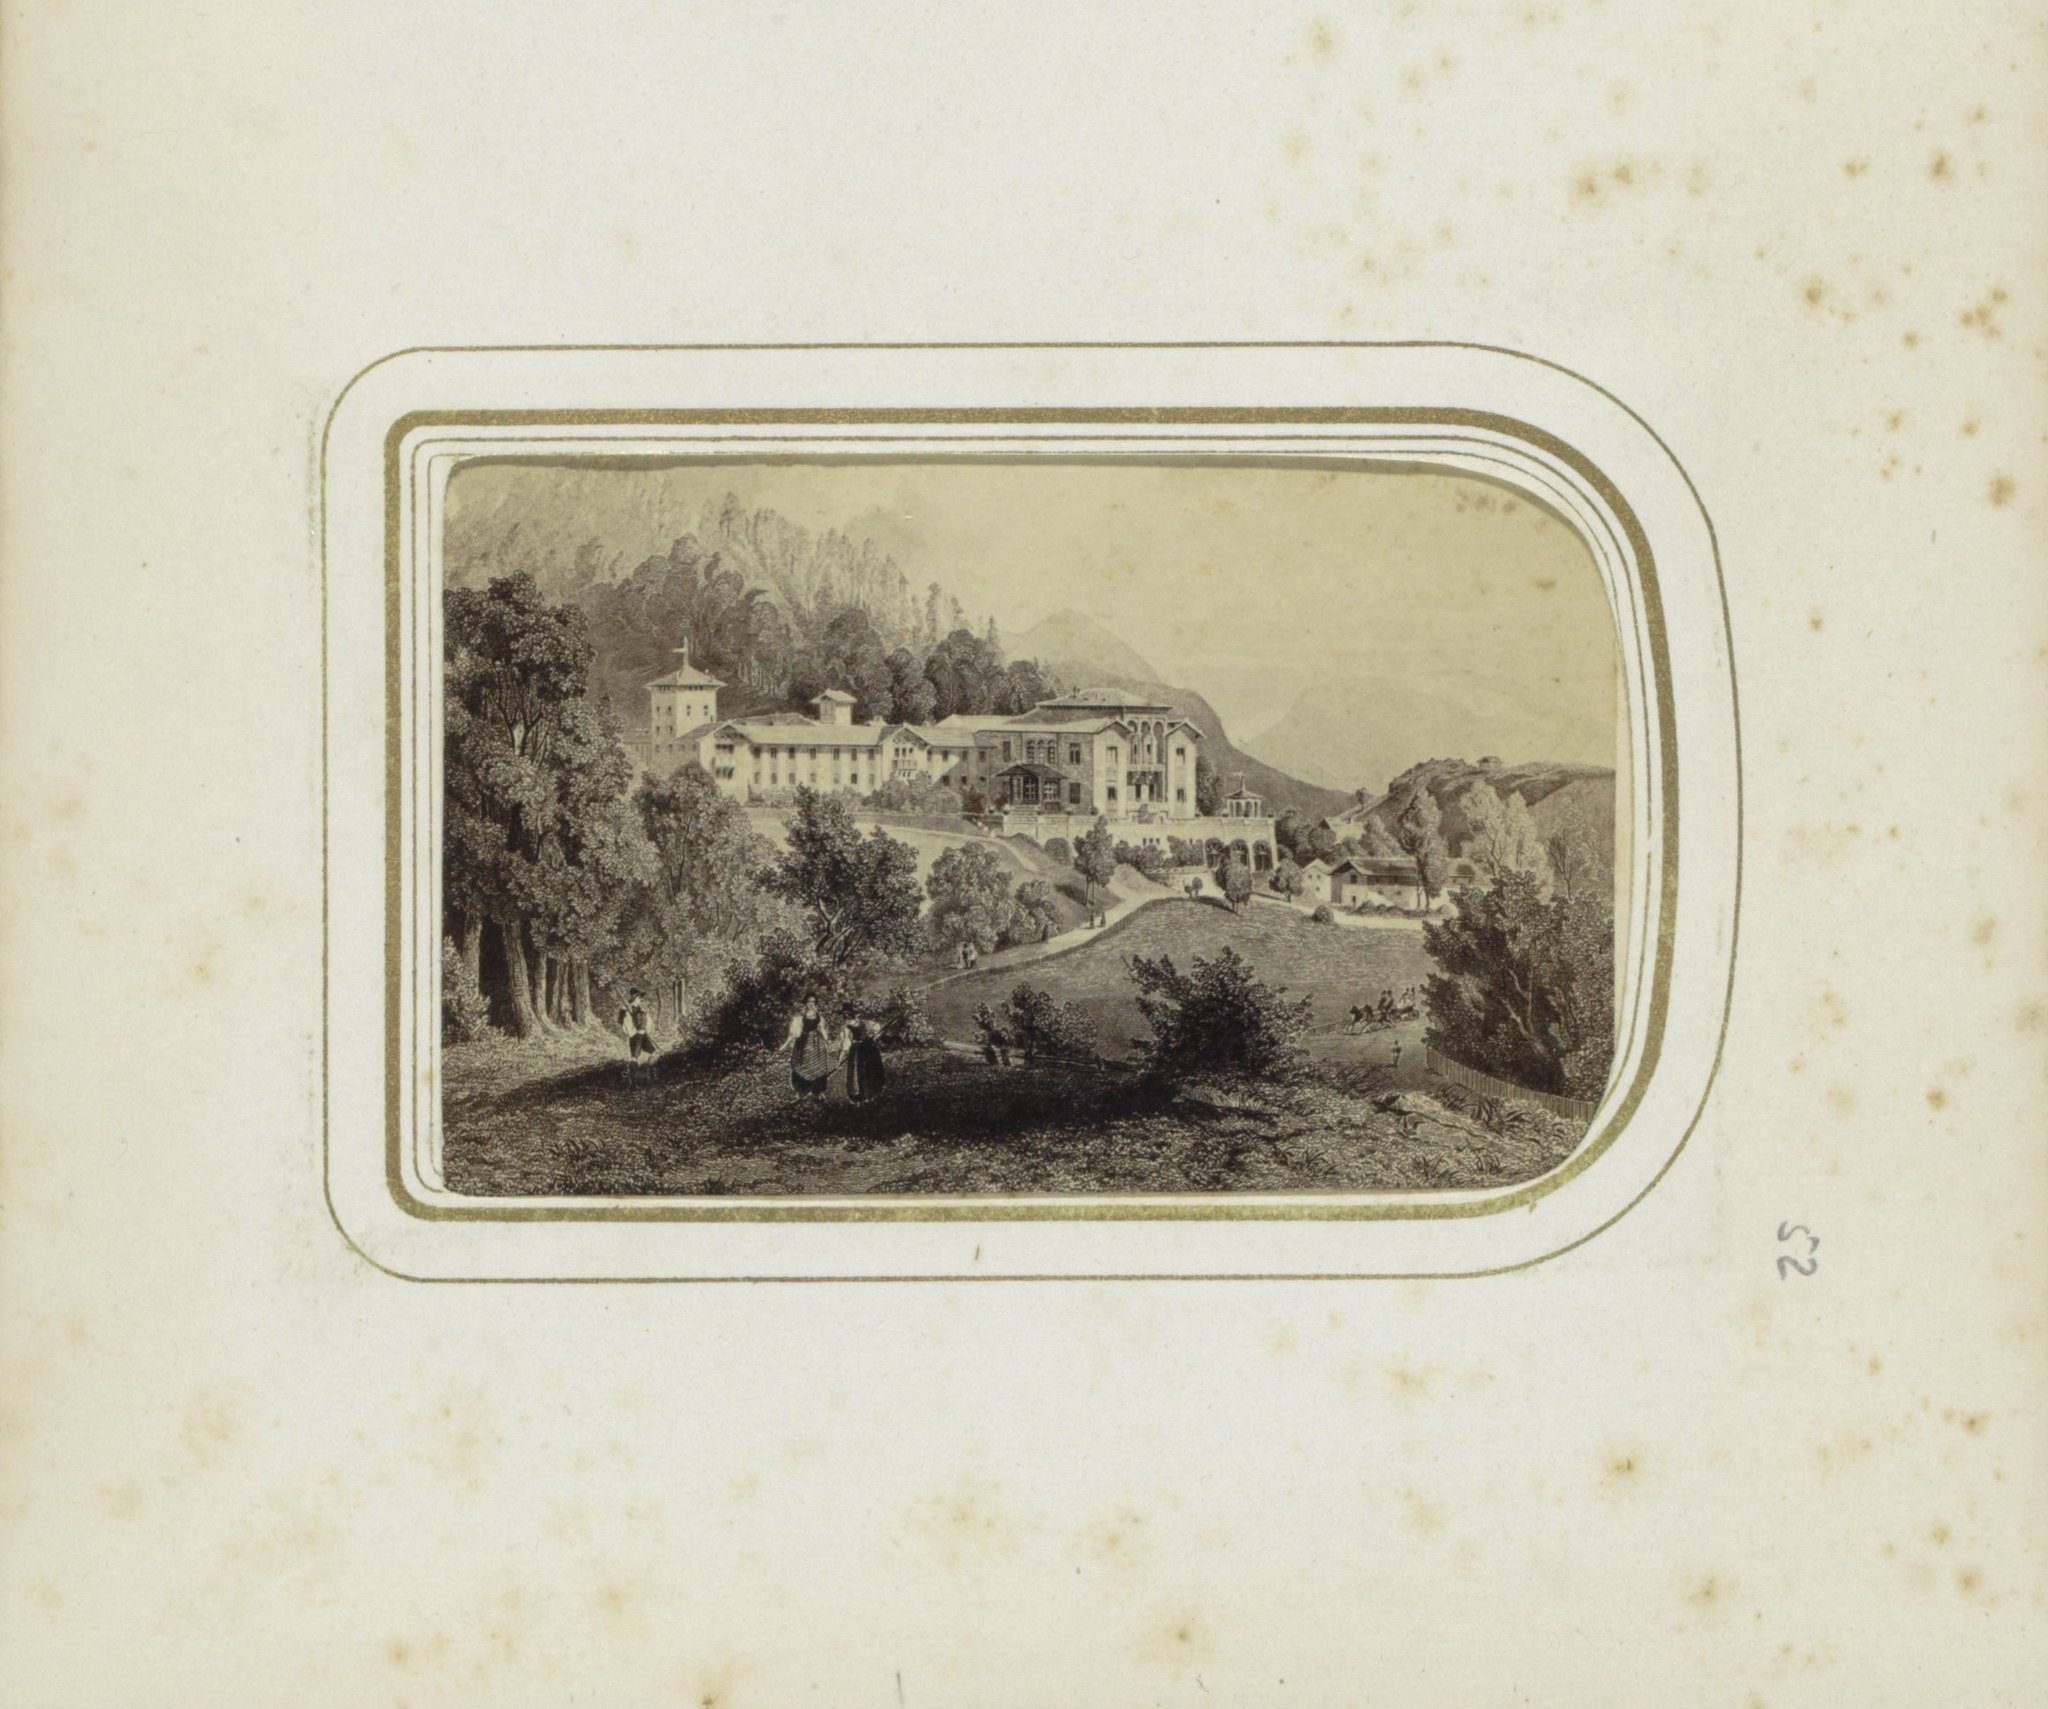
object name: photograph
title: Fotoreproductie van een prent van de Koninklijke Villa in Berchtesgaden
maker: Anonymous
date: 1865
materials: paper, photographic support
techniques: albumen print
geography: germany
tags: village, travelling; tourism, villa, exterior ~ representation of a building, parts of church exterior and annexes: tower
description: Onderdeel van Fotoalbum van een reis door Zwitserland, Oostenrijk en Duitsland door de Nederlandse familie Derkinderen.